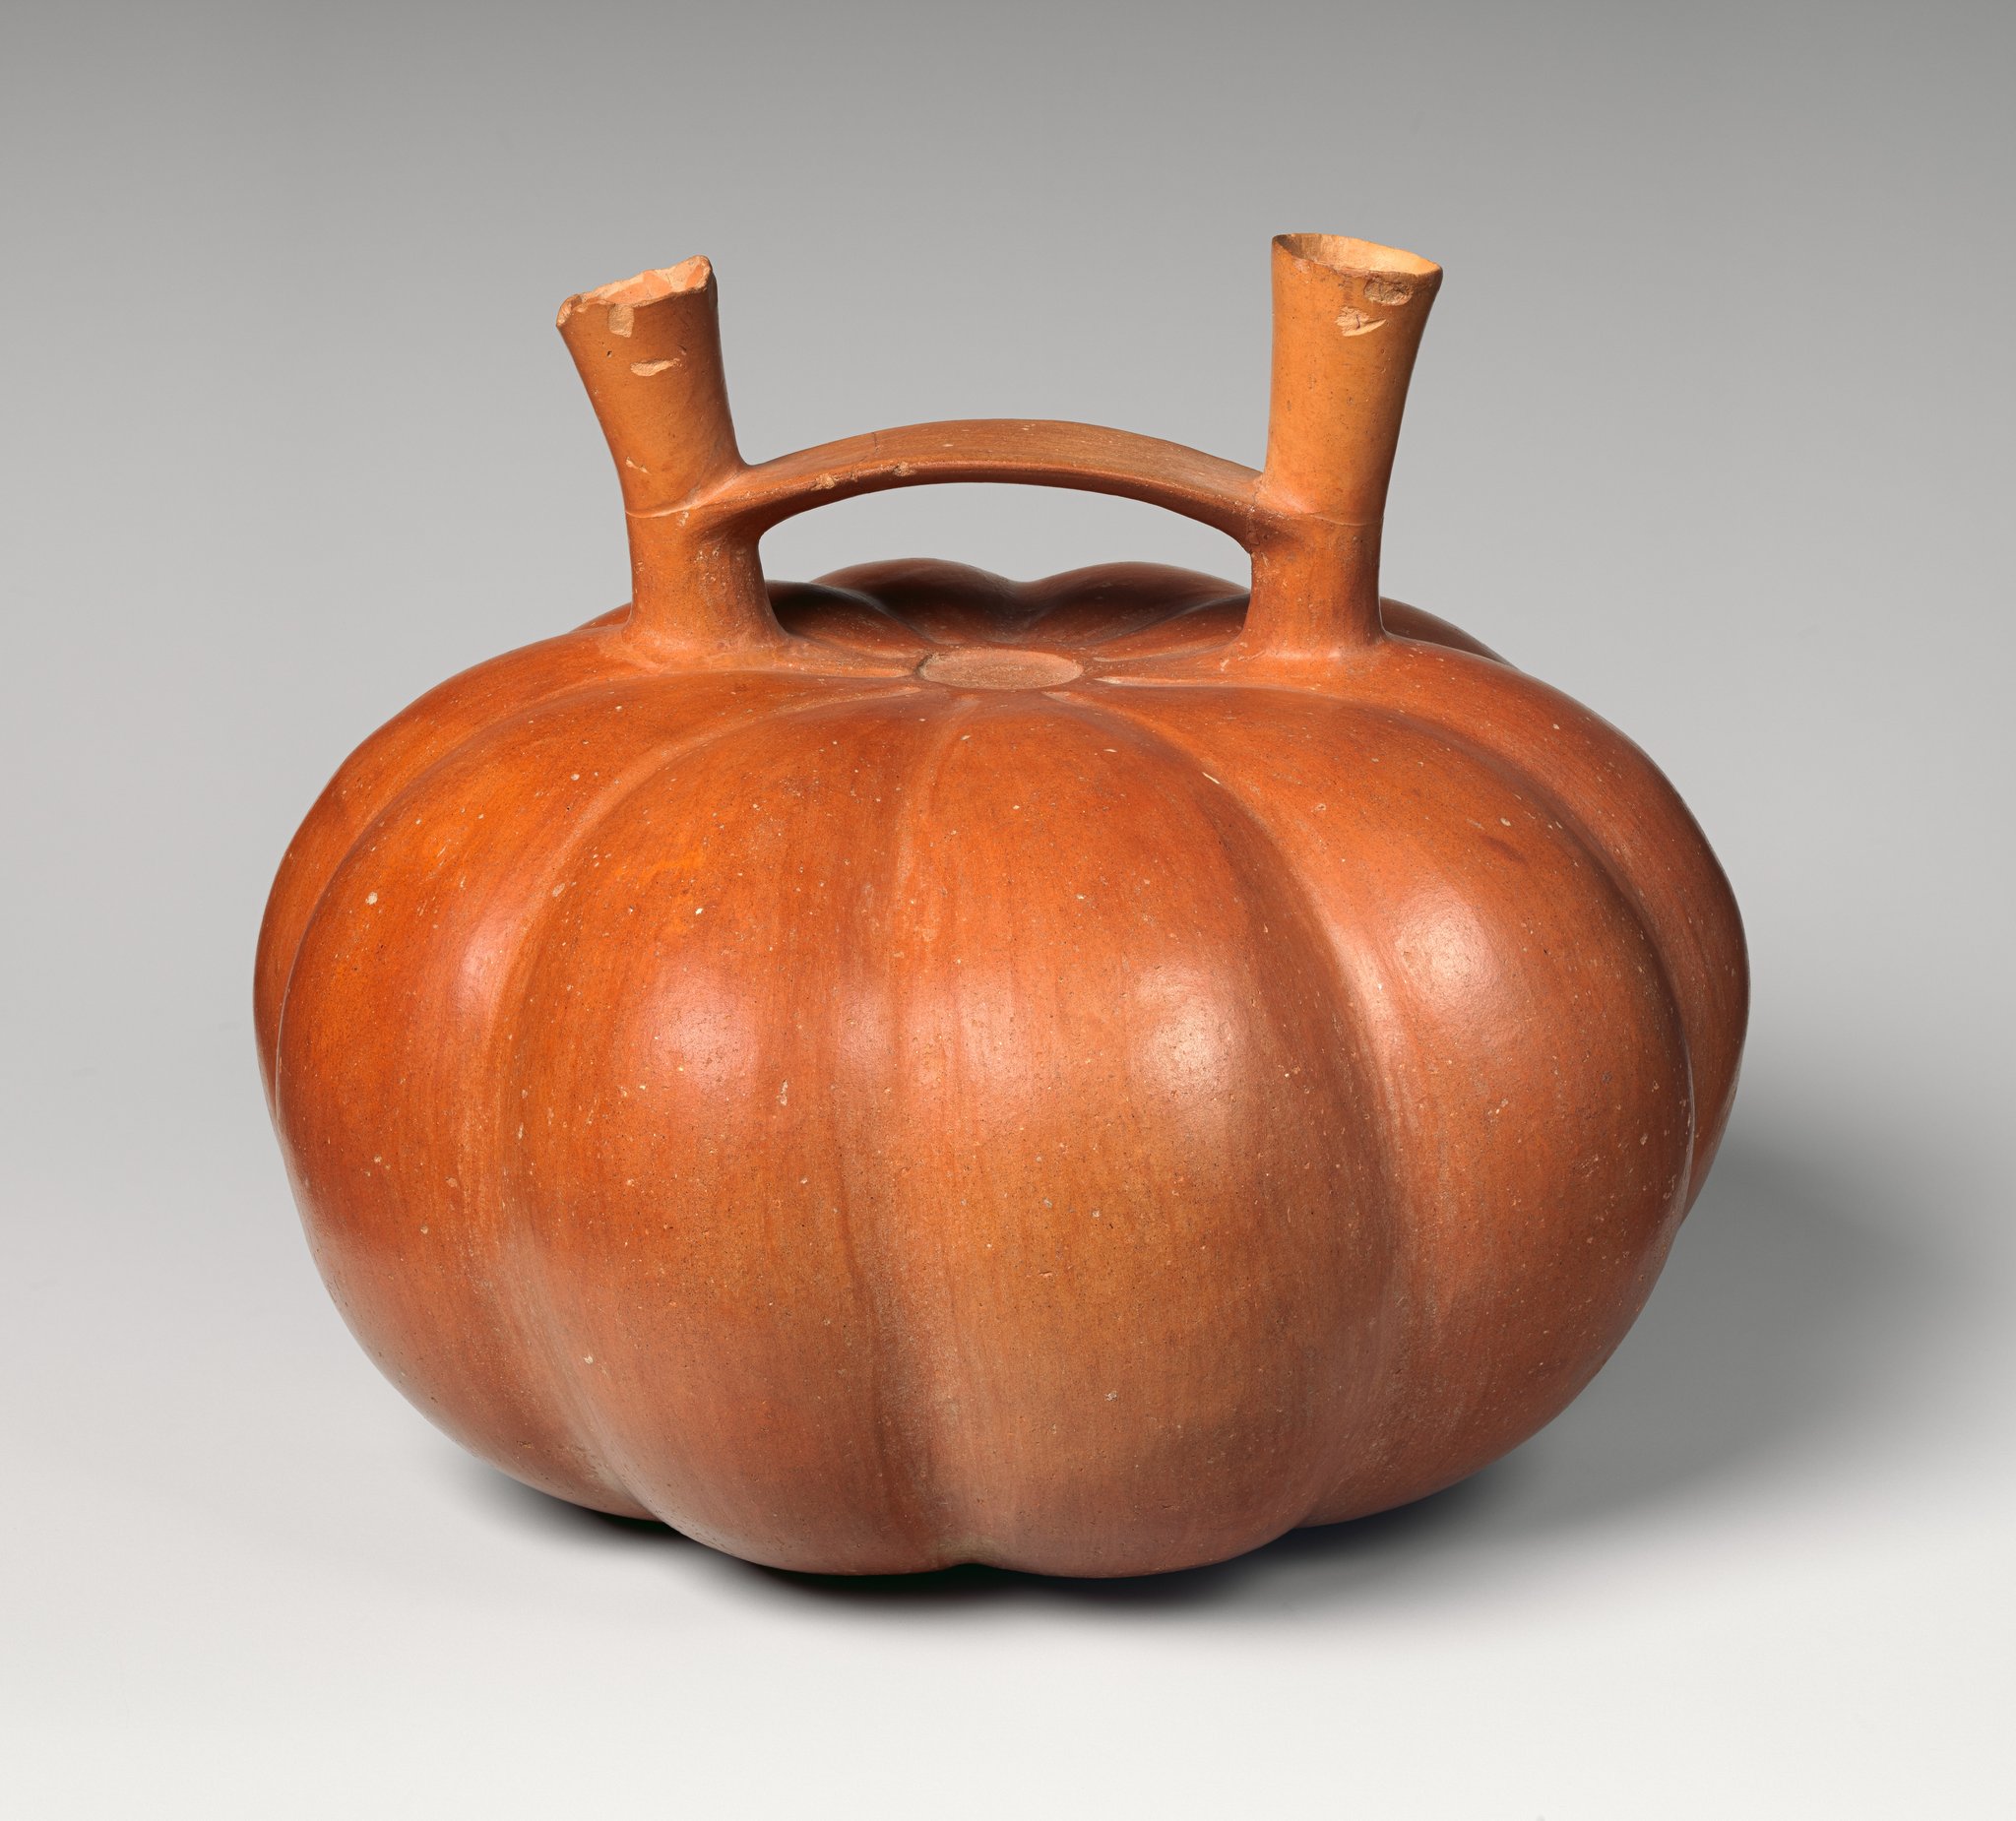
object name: bottle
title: Gourd-shaped bottle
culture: topará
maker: topará artist(s)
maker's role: artist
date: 200 BCE-100 CE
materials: ceramic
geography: peru